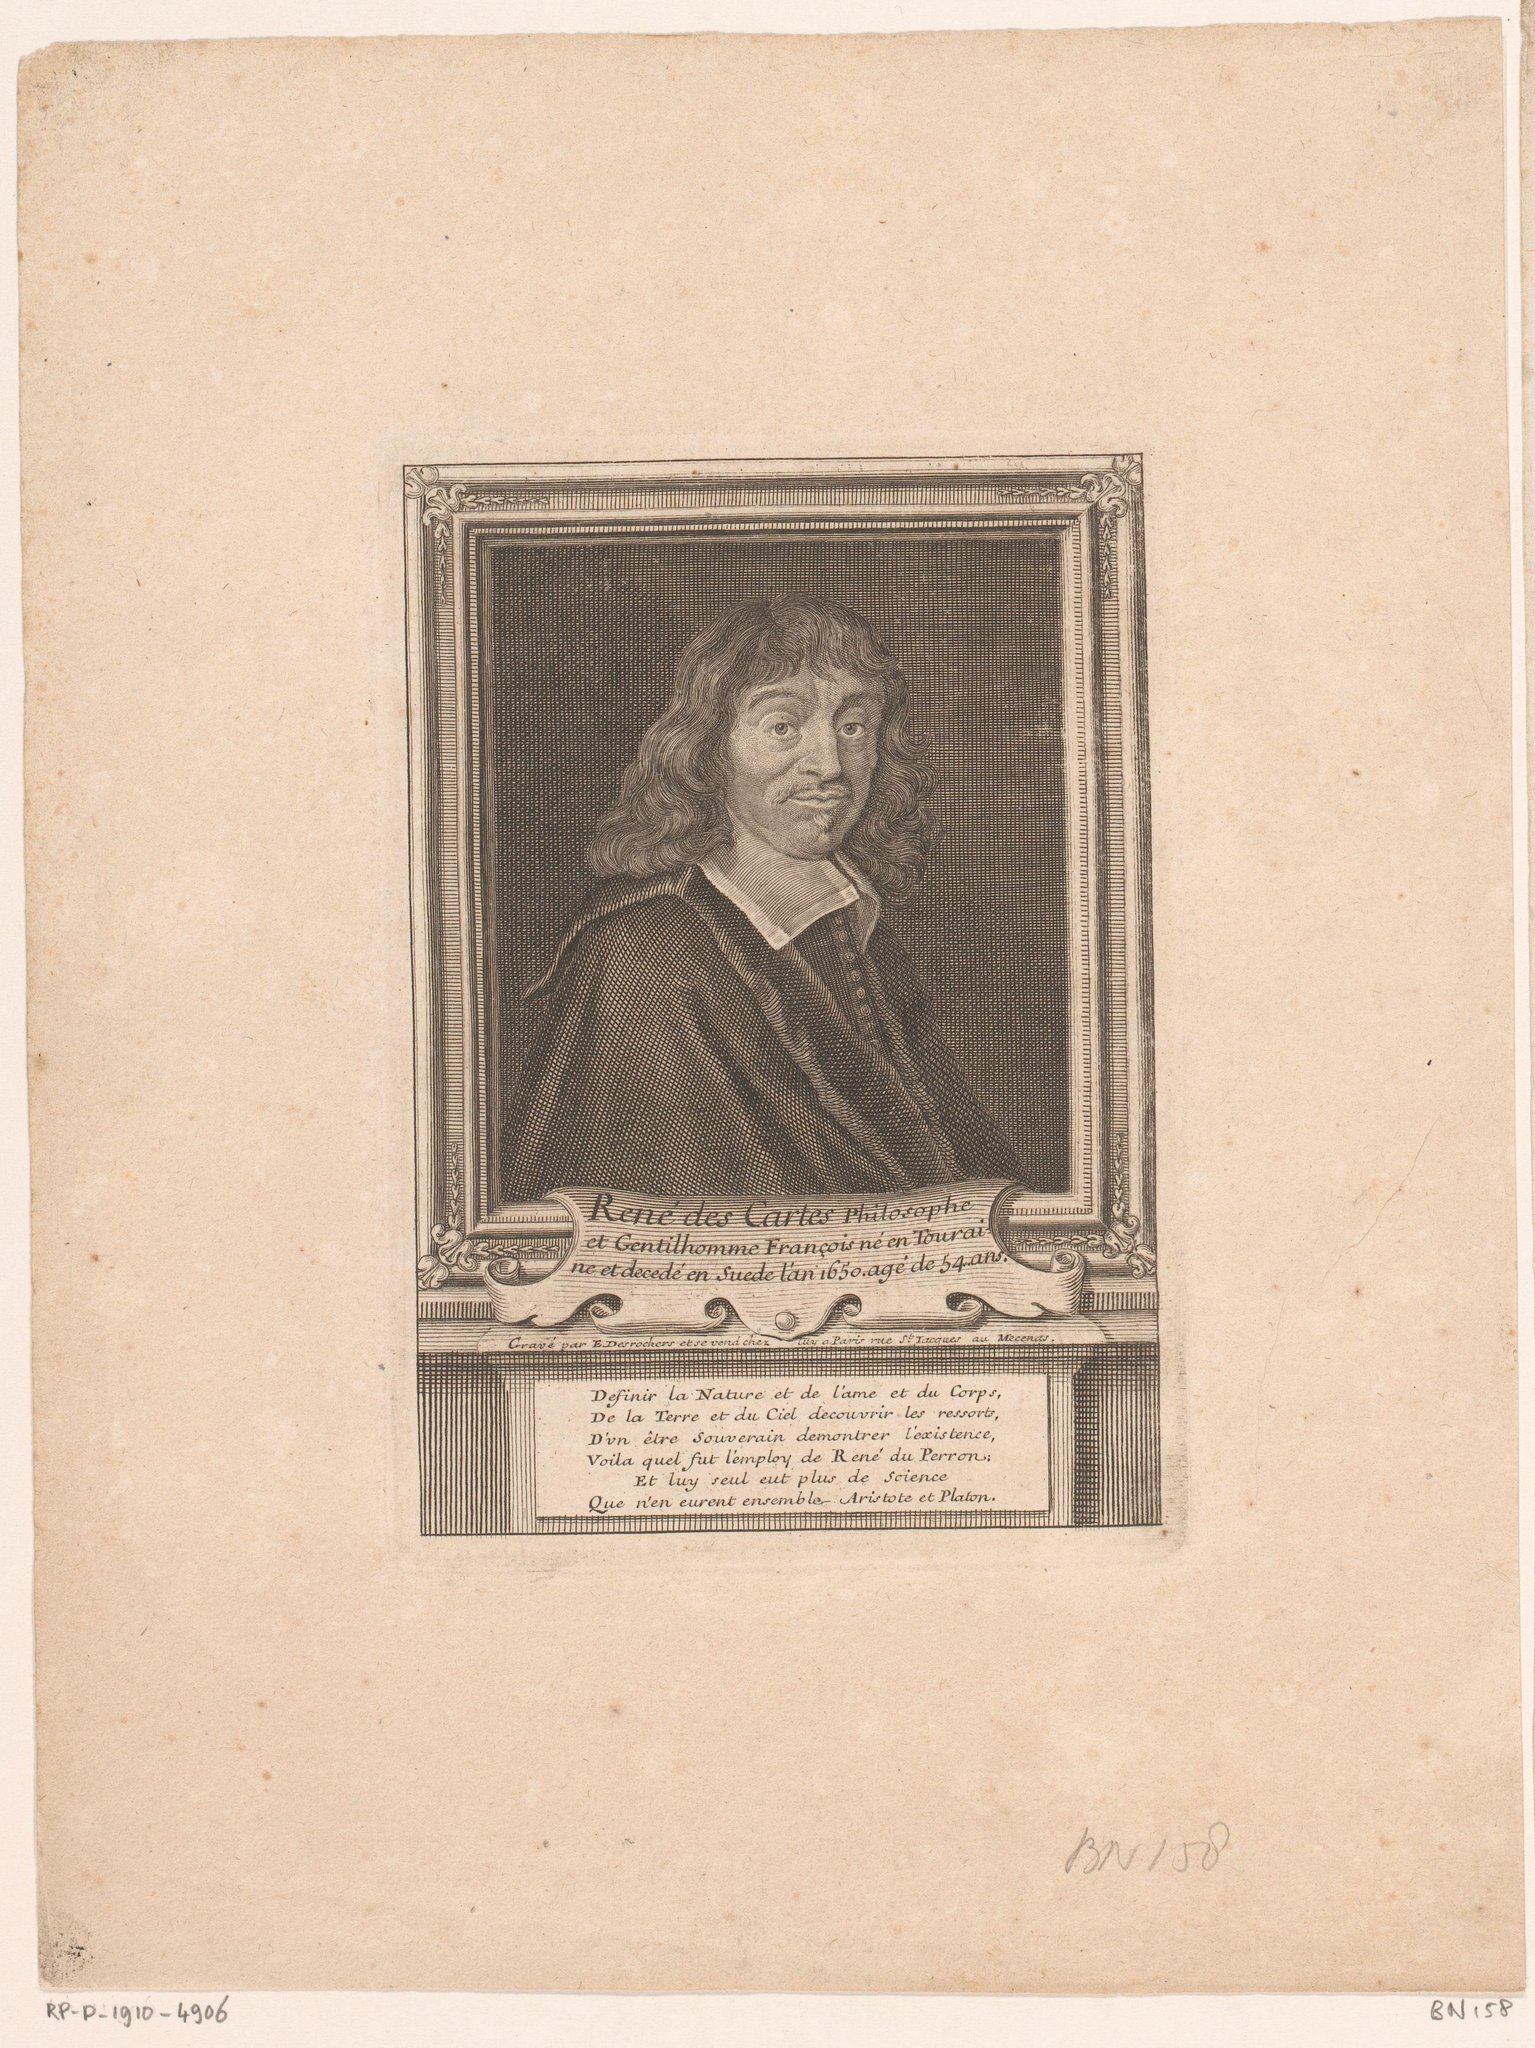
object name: print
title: Recueil de portraits (...)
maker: étienne desrochers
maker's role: print maker, publisher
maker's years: 1668-1741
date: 1726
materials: paper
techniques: engraving, etching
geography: paris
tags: rené descartes, scholar, philosopher, historical persons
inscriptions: collector's mark: Lugt 2228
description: Behoort waarschijnlijk tot een serie portretten, grotendeels door Etienne Desrochers, getiteld: 'Recueil de portraits de personnes qui se sont distinguées tant dans les Armes que dans Belles-Lettres et les Arts, comme aussi la famille royale de France et autres cours étrangères'. De serie werd initieel uitgegeven door Desrochers en aangekondigd in 'Mercure' in mei 1726, p. 985. Echter was Desrochers reeds enkele jaren eerder begonnen met het uitgeven van de serie. Na de dood van Desrochers werd de serie voortgezet door Gilles Edme Petit. Een latere staat werd uitgegeven door Jean François Daumont in Parijs.